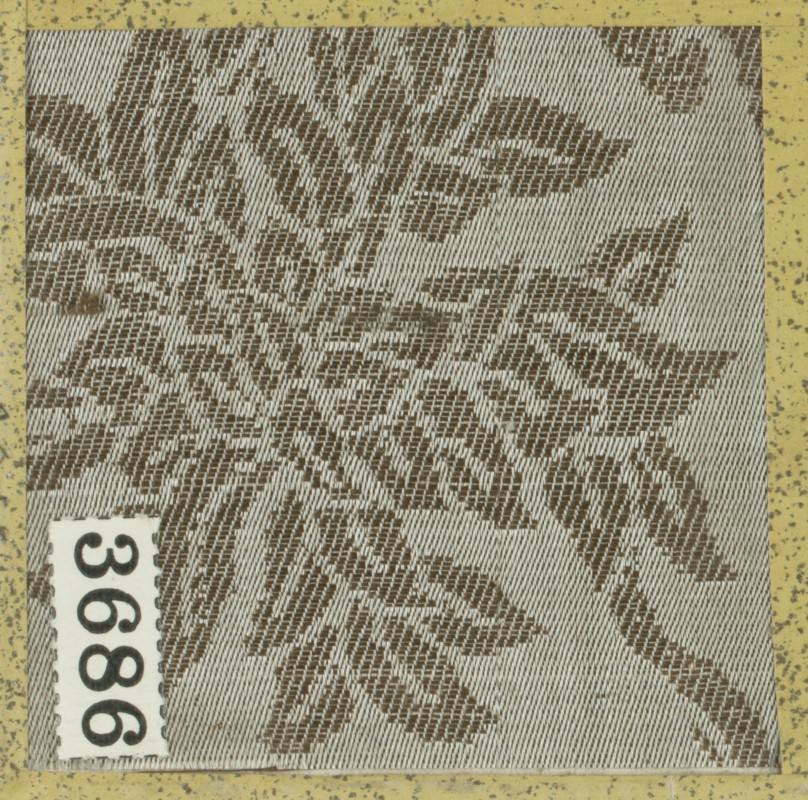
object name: sample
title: Textile Sample from Sample Book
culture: japanese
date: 1801-1900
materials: silk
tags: flowers